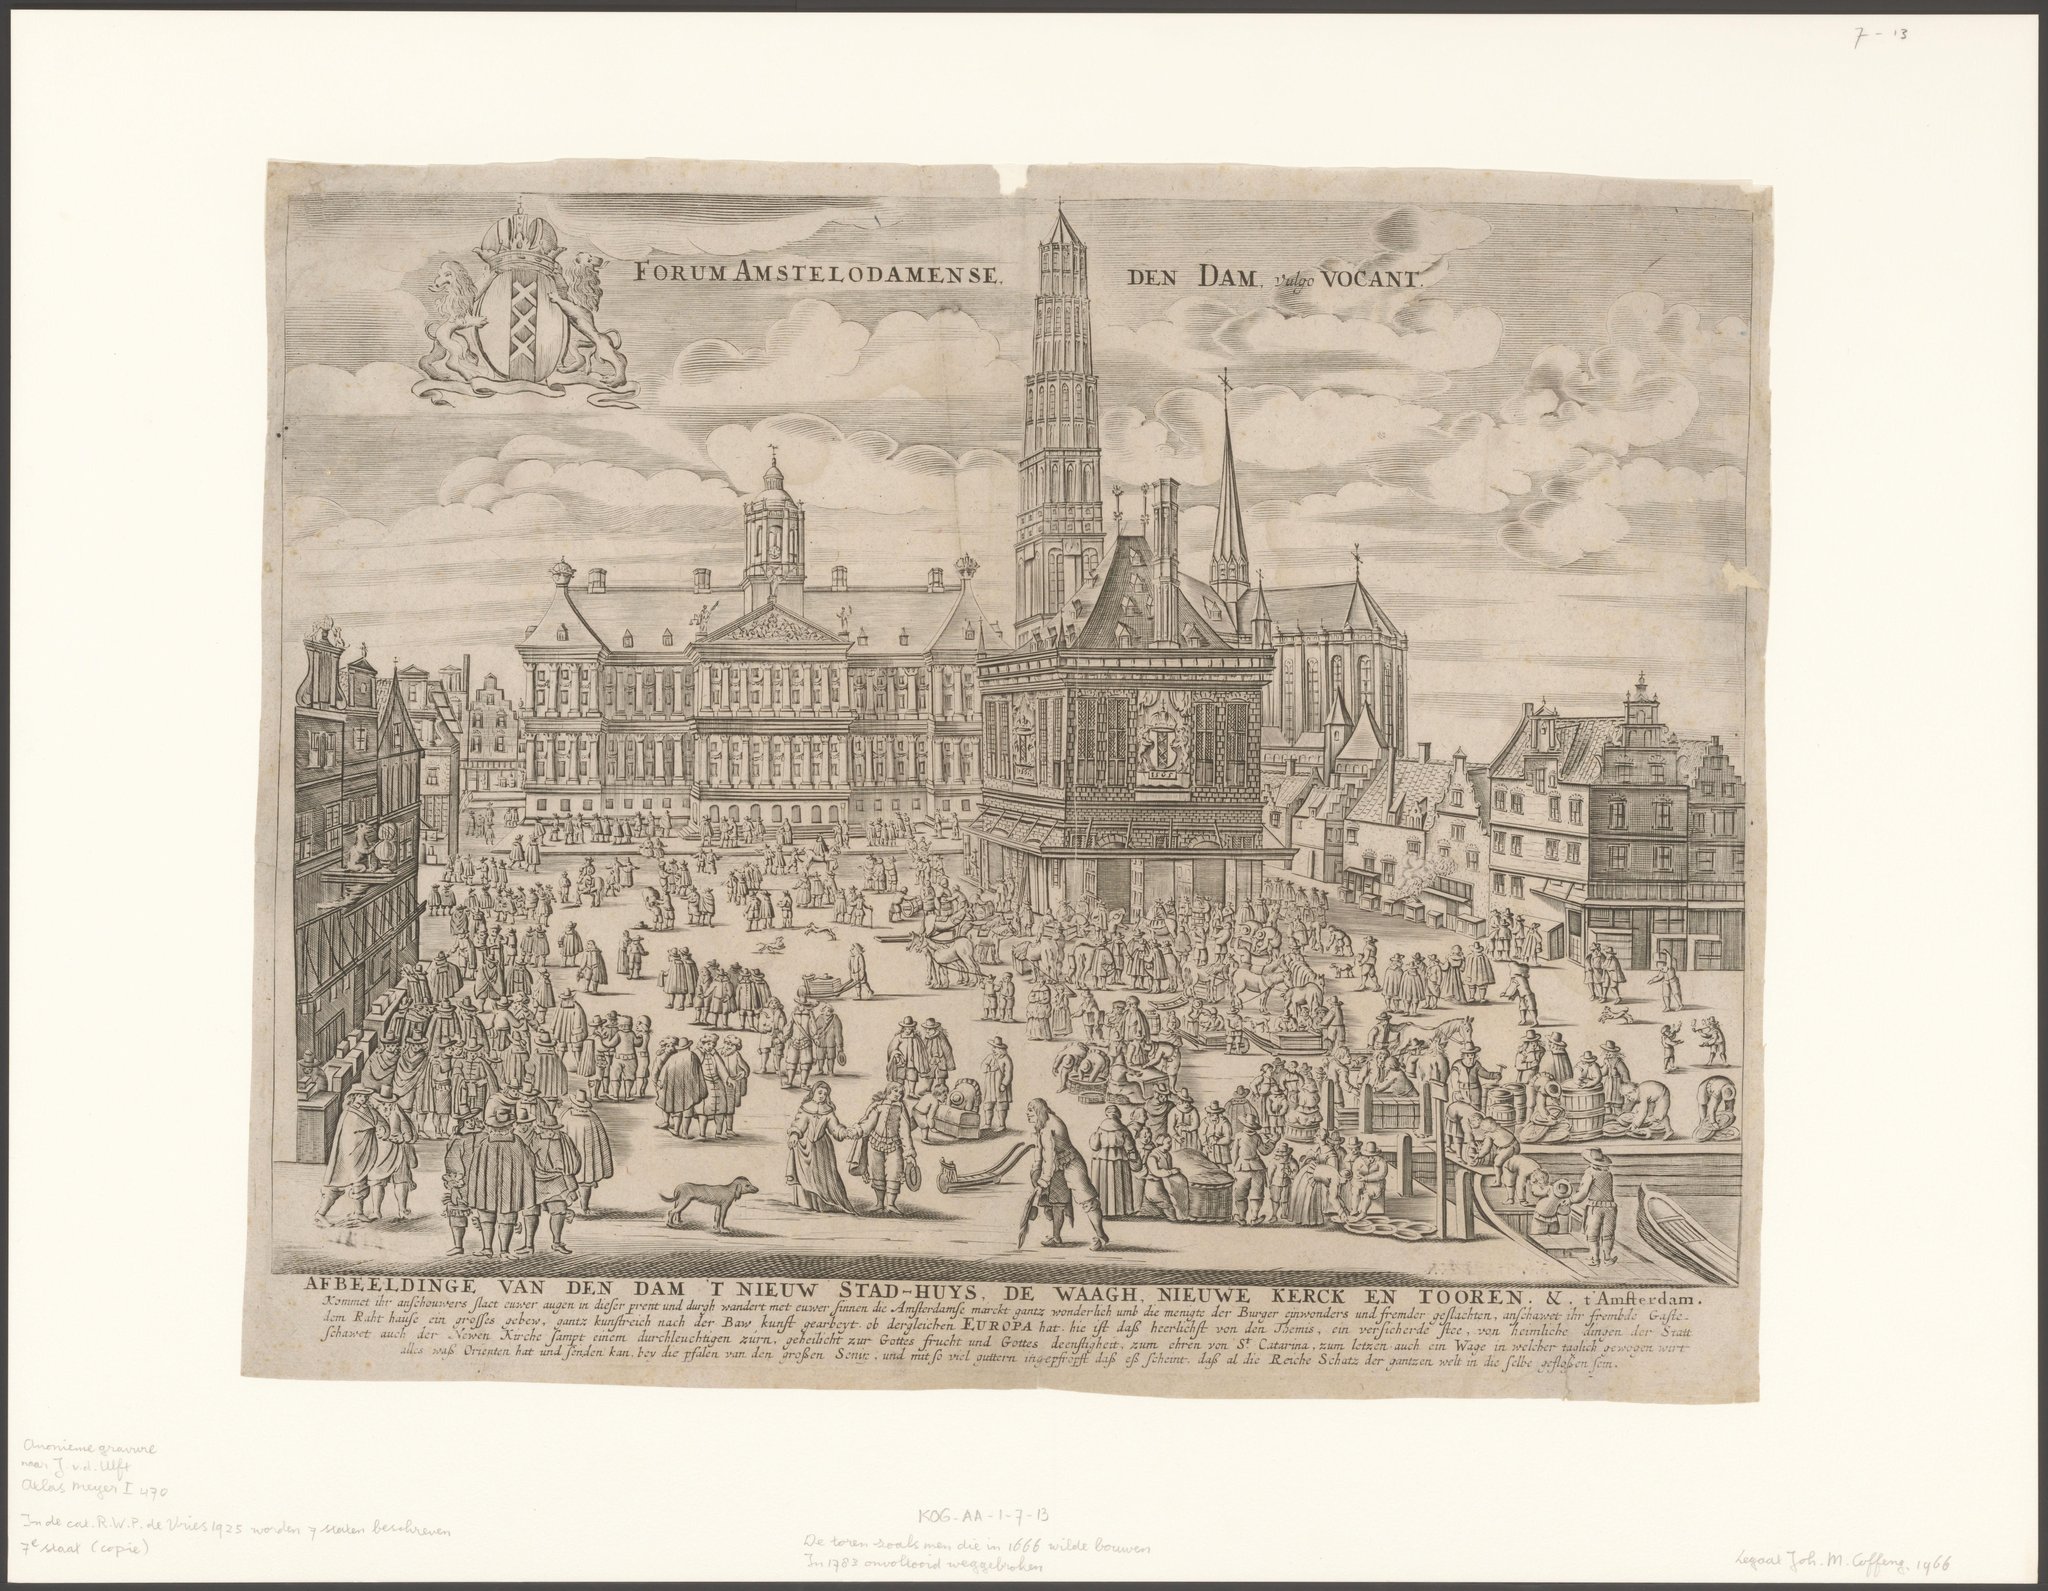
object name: print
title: Gezicht op het Stadhuis, de Nieuwe Kerk en de Waag op de Dam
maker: Anonymous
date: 1650-1750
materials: paper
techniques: engraving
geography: amsterdam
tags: square, place, circus, etc., city-view in general; 'veduta', church (exterior), townhall, weigh-house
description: Onderwerpsrubriek binnen de Atlas Amsterdam: Dam (voor 1835).